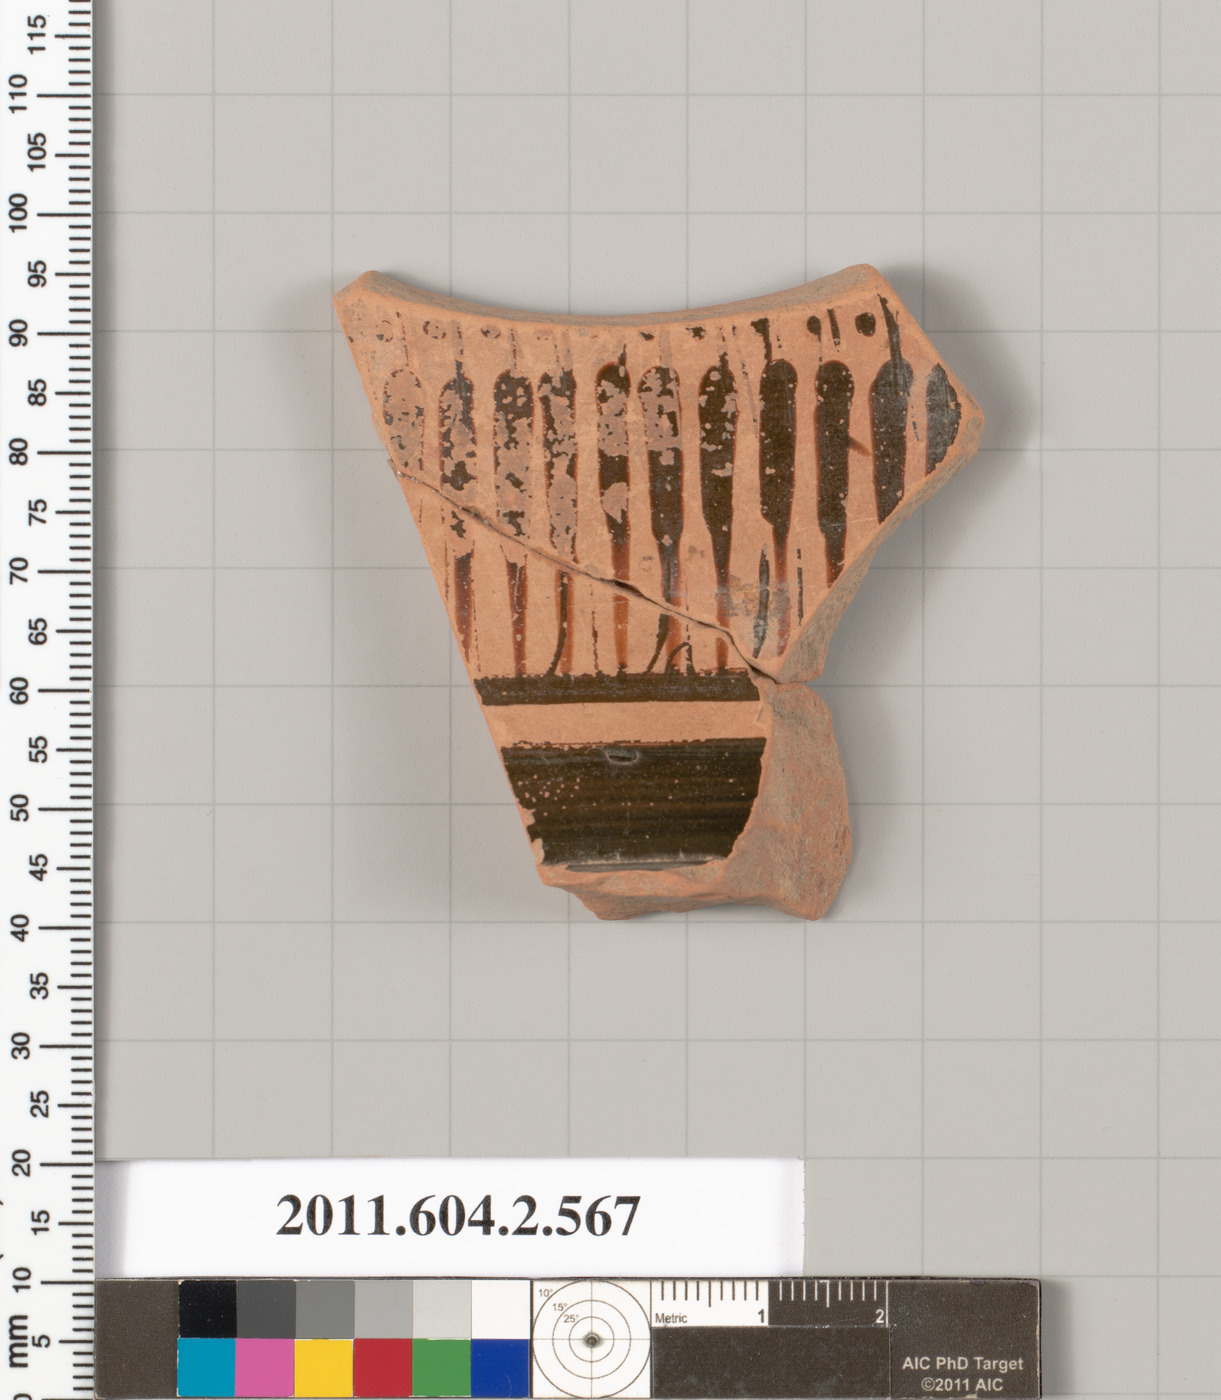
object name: column krater fragment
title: Terracotta fragment of a column-krater (bowl for mixing wine and water)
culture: greek, attic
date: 460-450 BCE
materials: terracotta